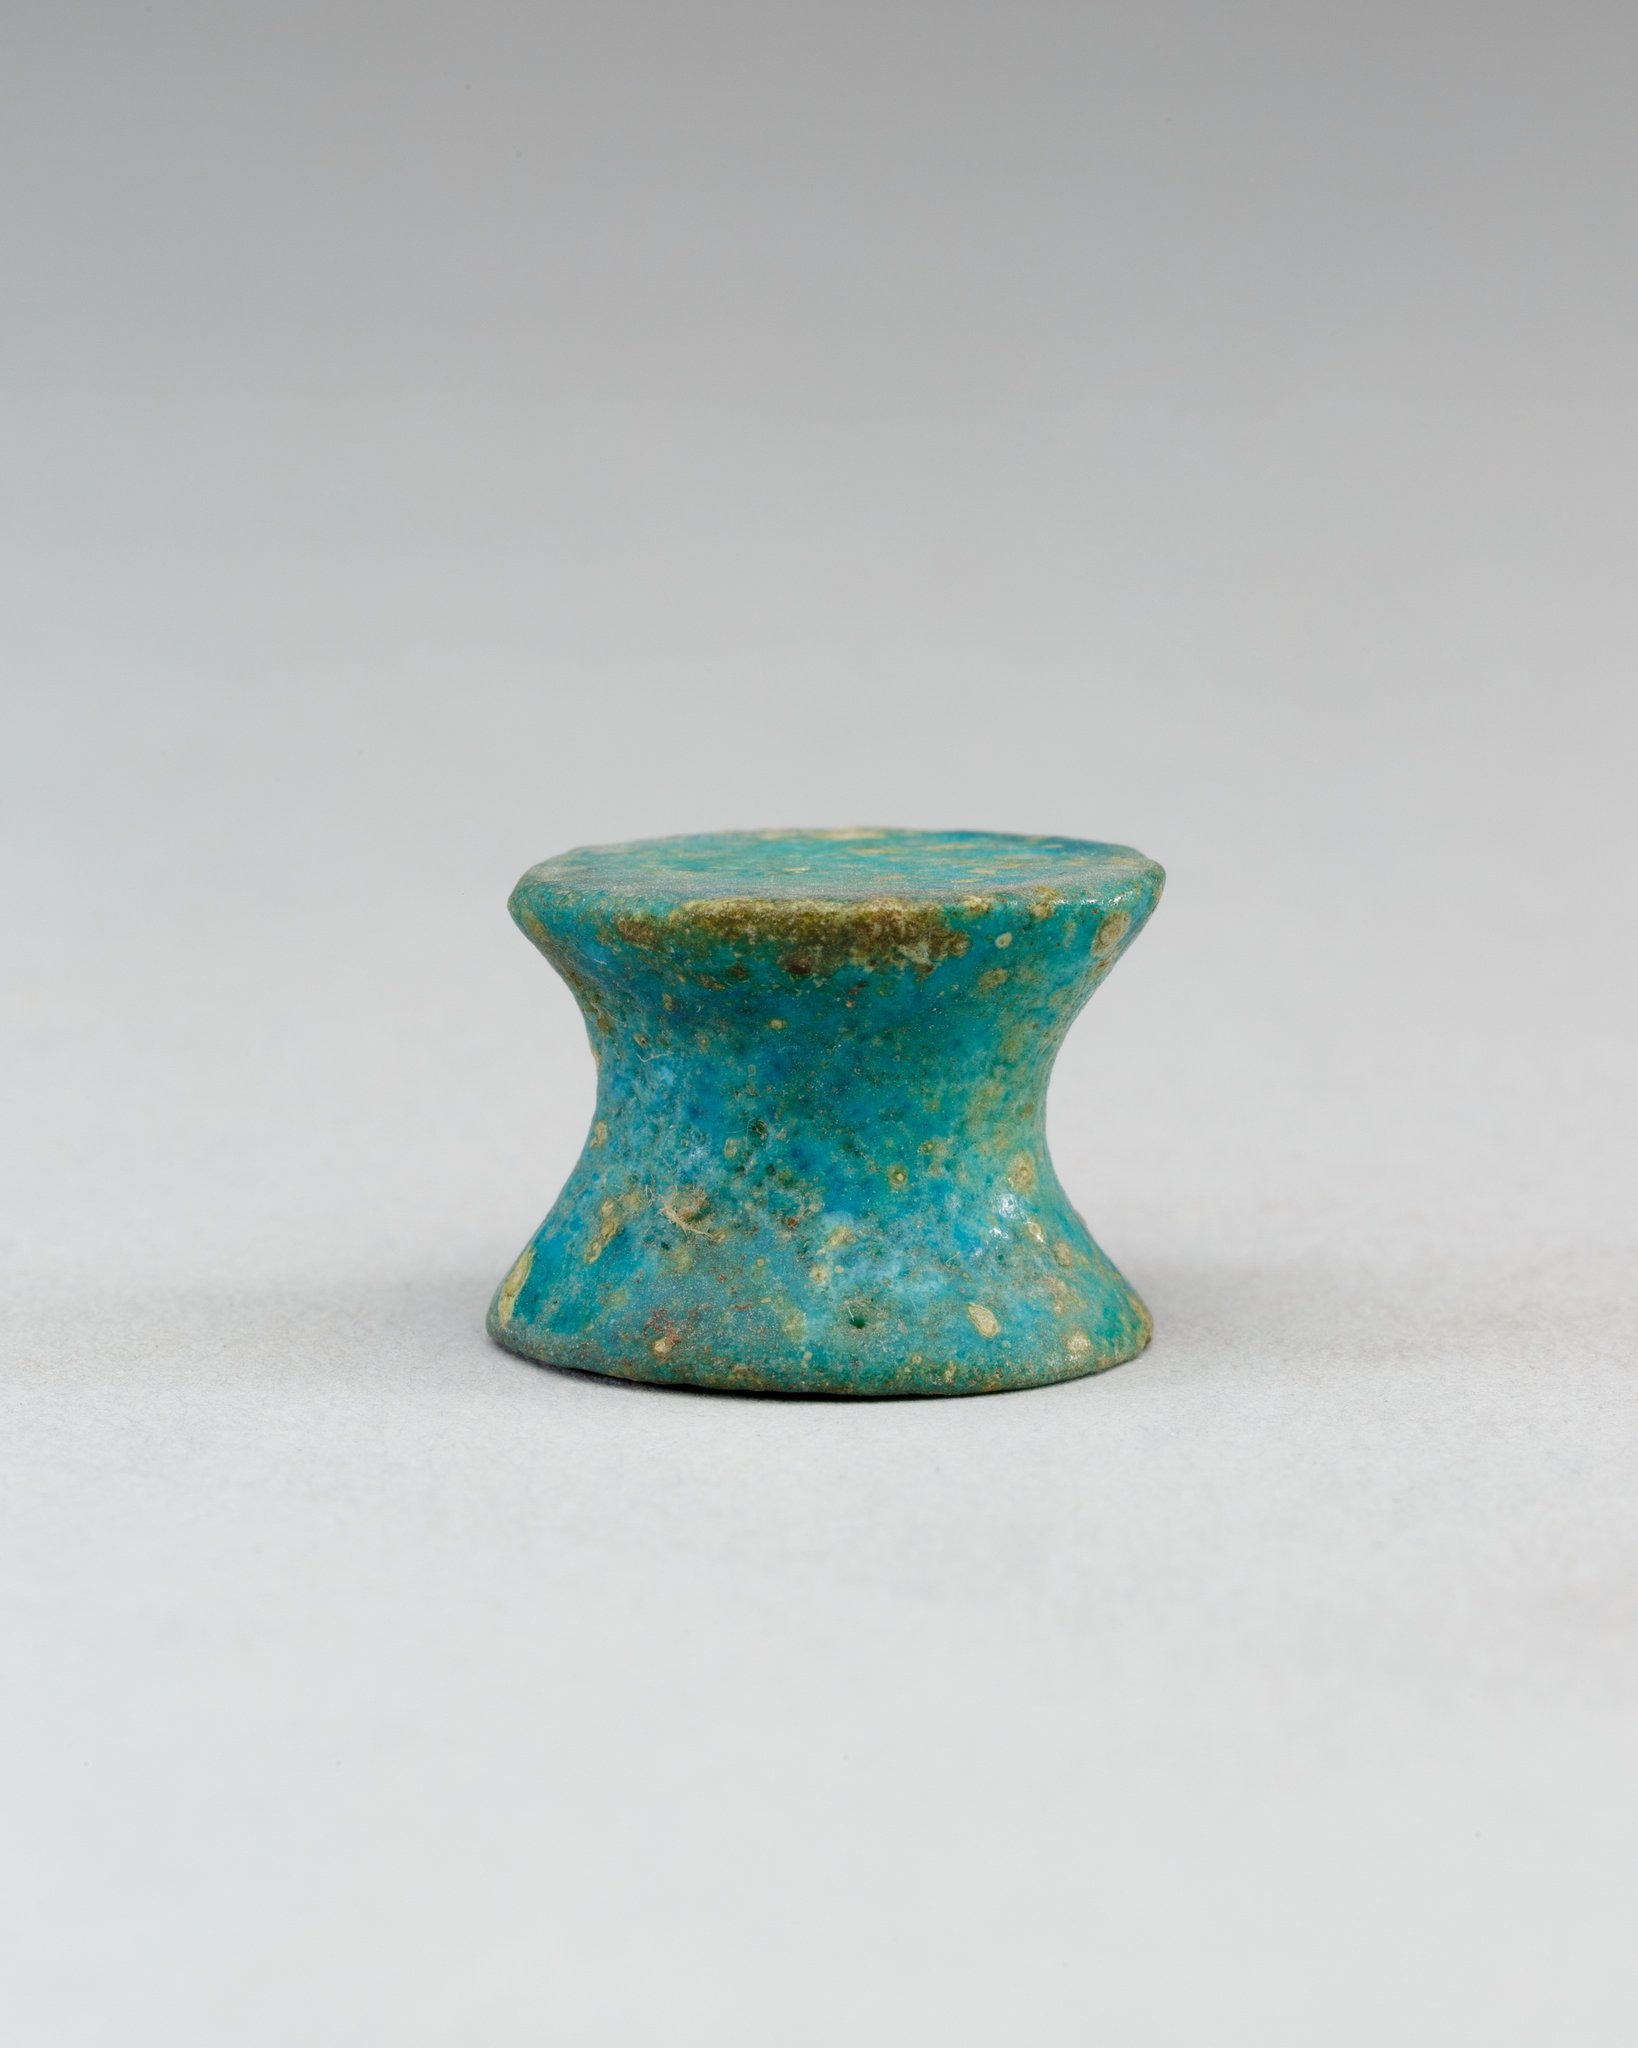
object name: game piece, spool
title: Spool-Shaped Game Piece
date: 1504-1447 BCE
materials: faience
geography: egypt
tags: games